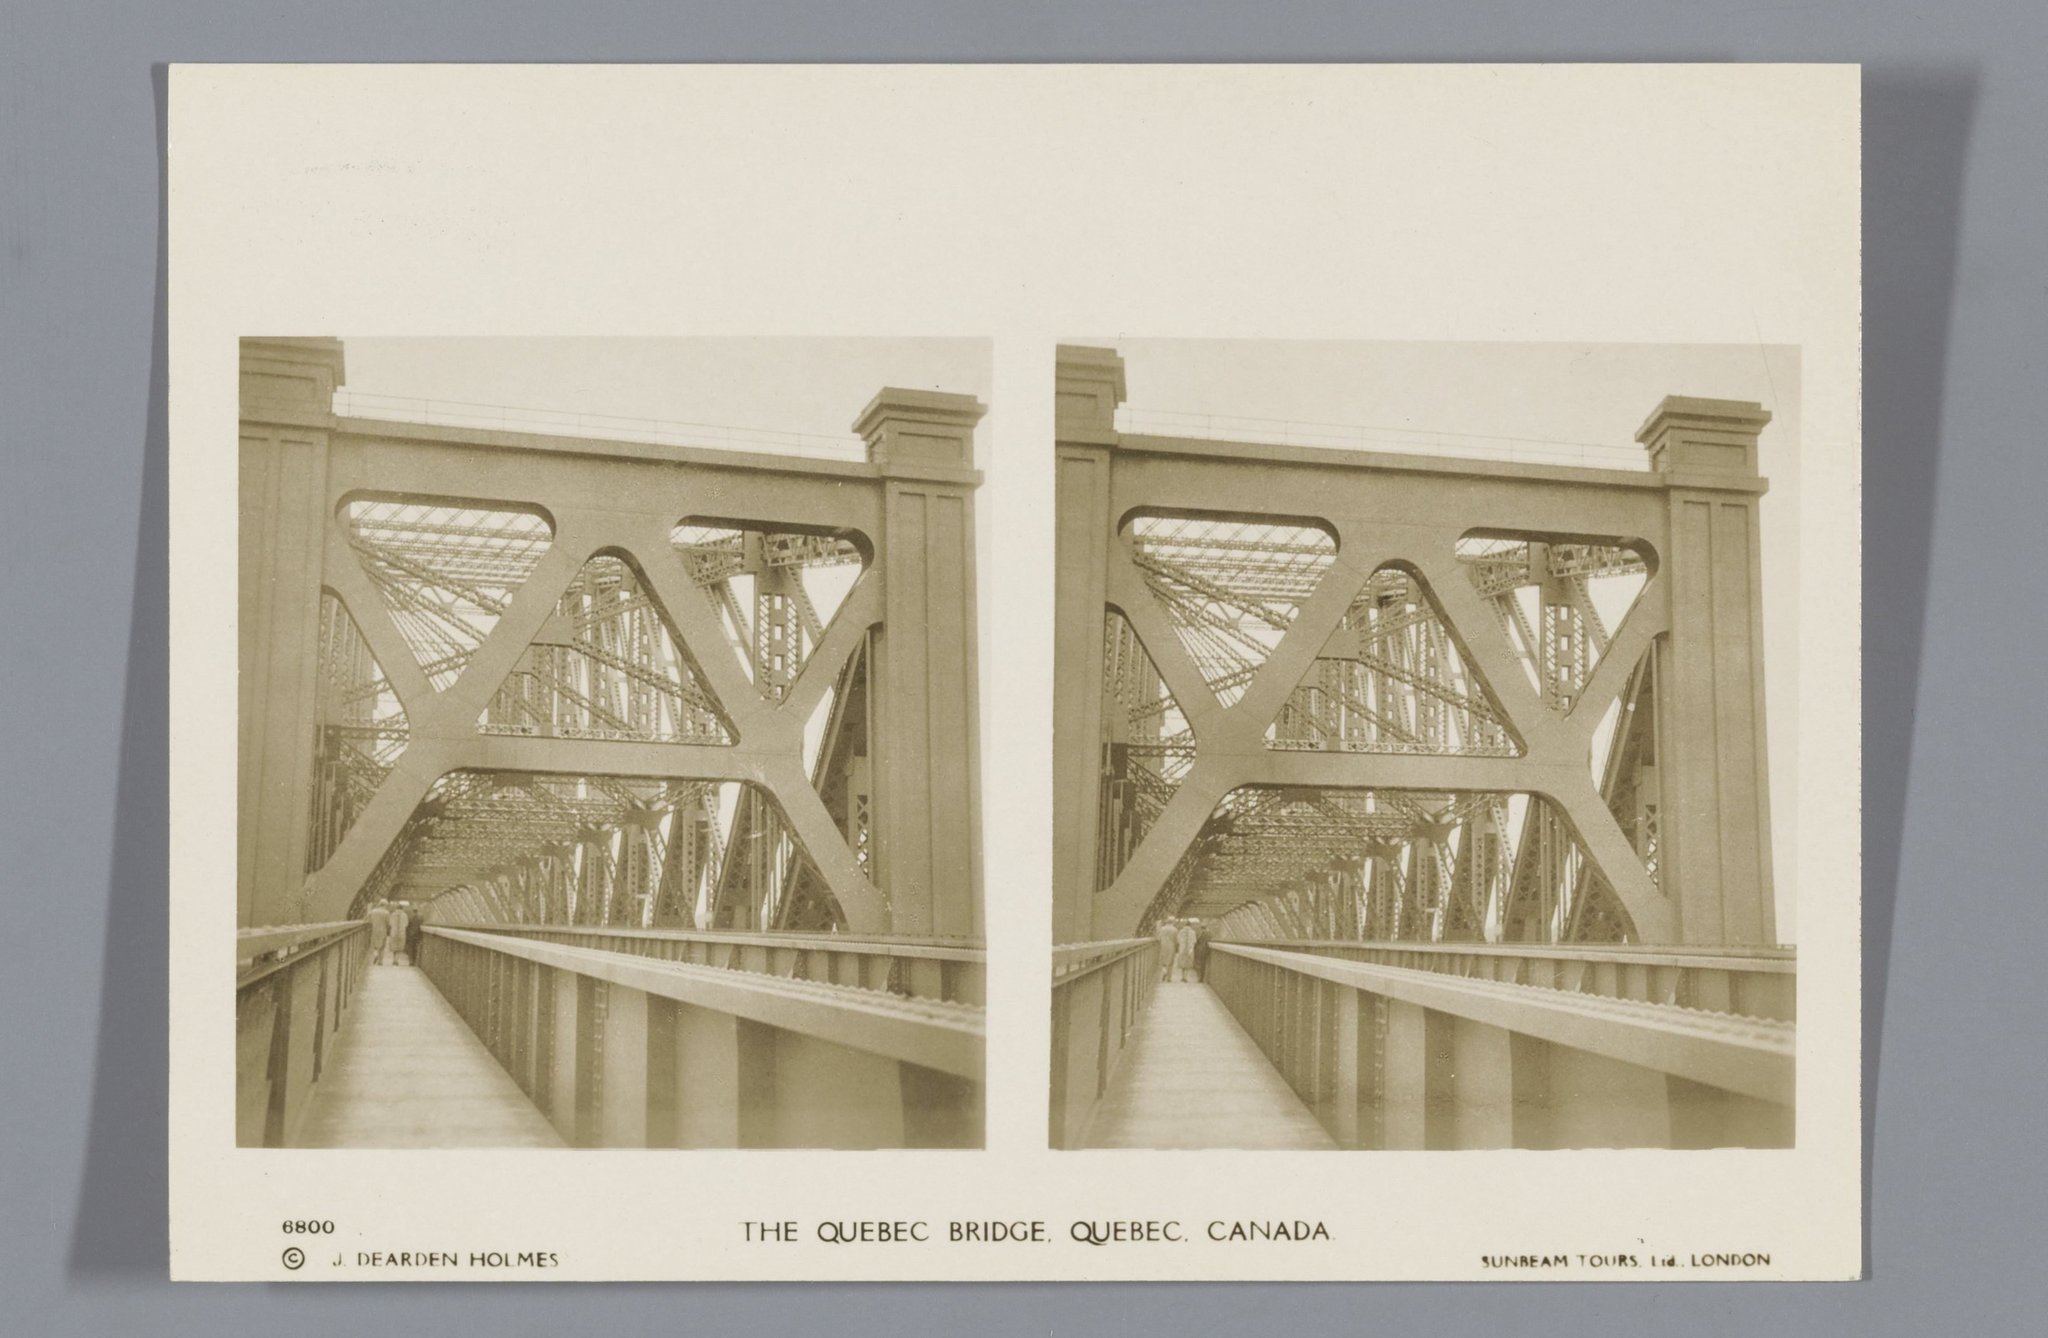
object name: stereograph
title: Voetpad over de Québecbrug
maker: james dearden holmes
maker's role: fotograaf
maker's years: 1873-1937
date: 1924-1926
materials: paper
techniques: gelatin silver print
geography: quebec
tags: cantilever bridge, québec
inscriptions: number: ‘6800’